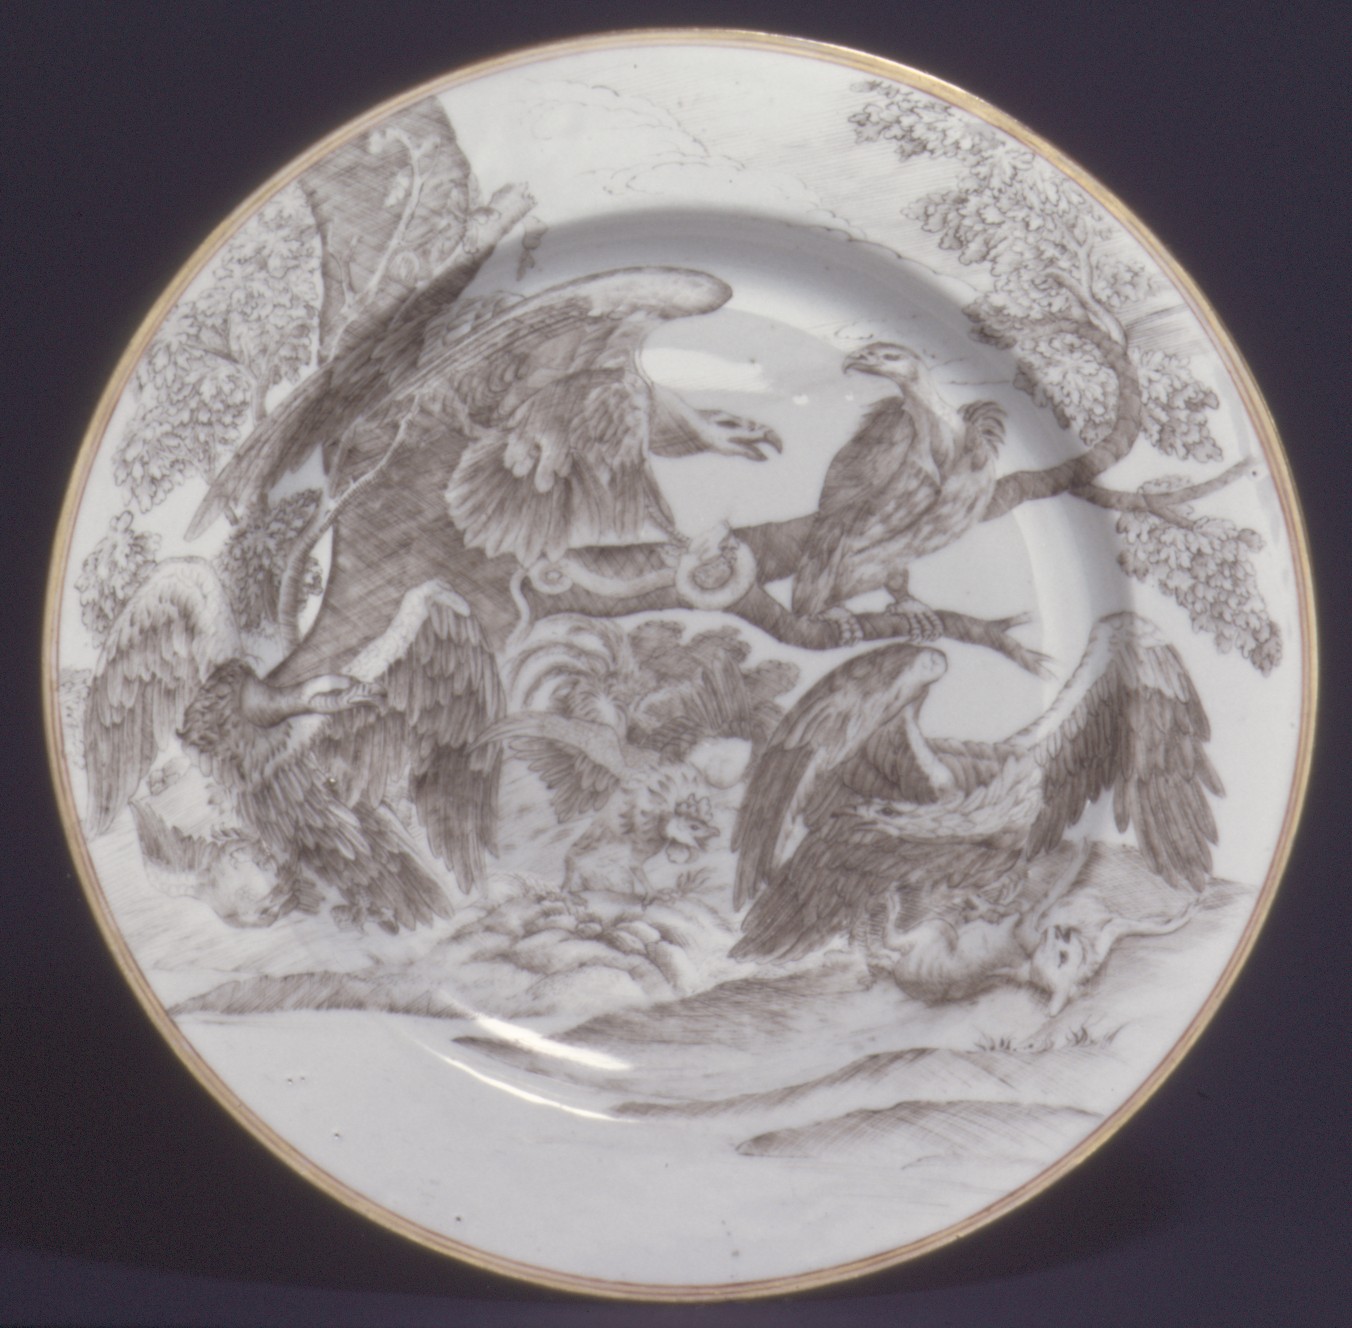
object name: plate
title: Plate (one of two)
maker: pieter boel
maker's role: artist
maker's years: 1622-1674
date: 1740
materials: hard paste porcelain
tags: birds